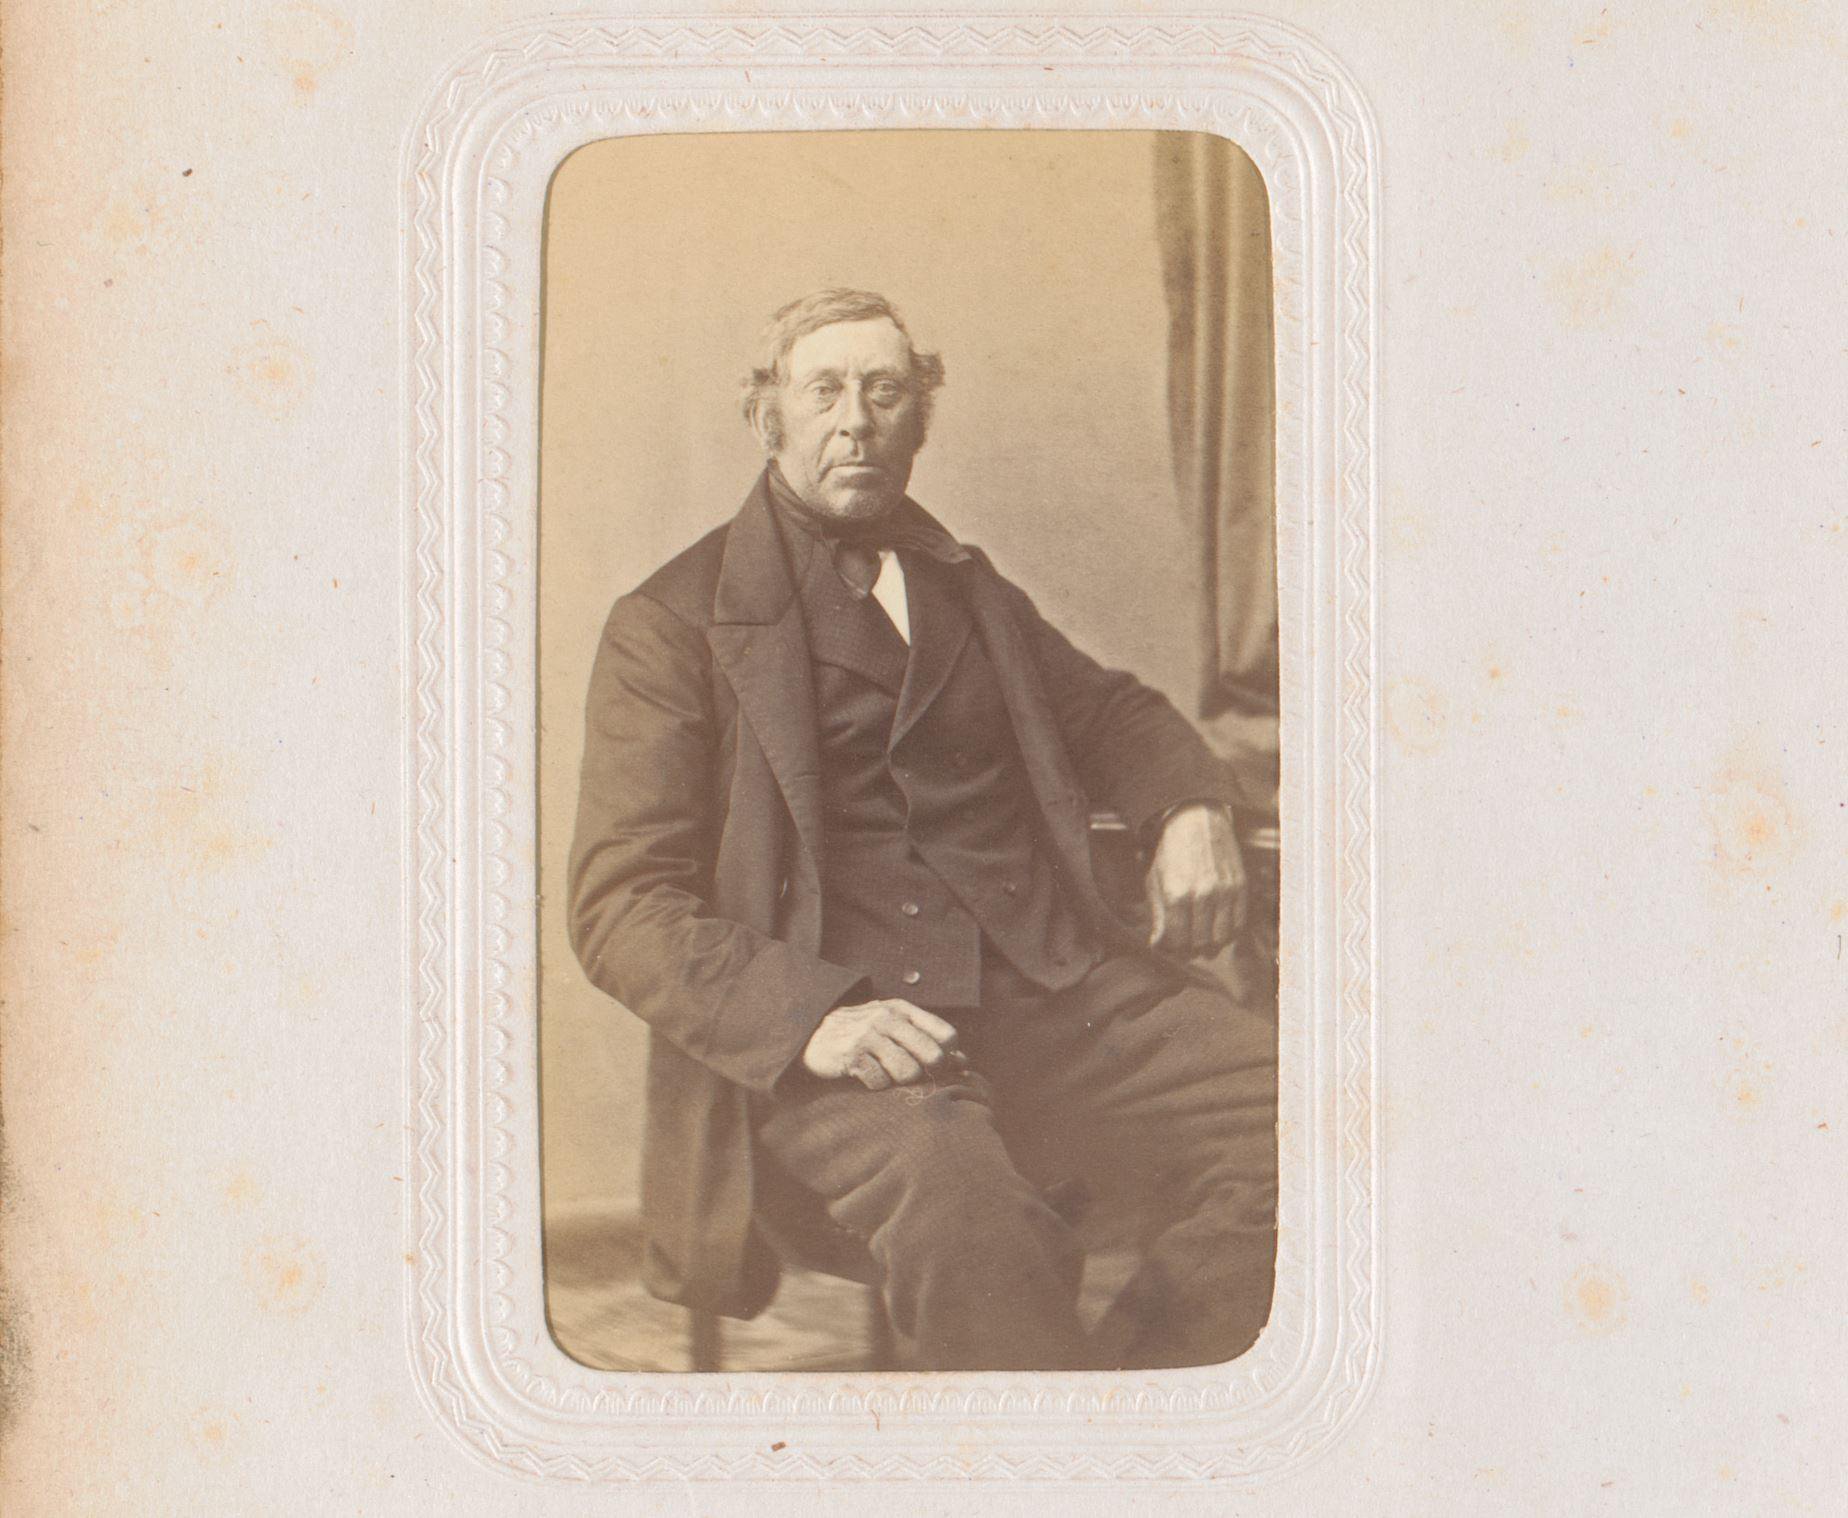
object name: photograph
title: Portret van een man, zittend aan een tafel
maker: kornelis willem schorteldoek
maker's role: boekbinder, fotograaf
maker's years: 1800-1885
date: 1855-1885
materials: cardboard, photographic support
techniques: albumen print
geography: gorinchem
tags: sitting figure, historical persons, table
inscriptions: inscription: ‘SCHORTELDOEK/ PHOTOGRAAF/ GORINCHEM/ Groote Markt’